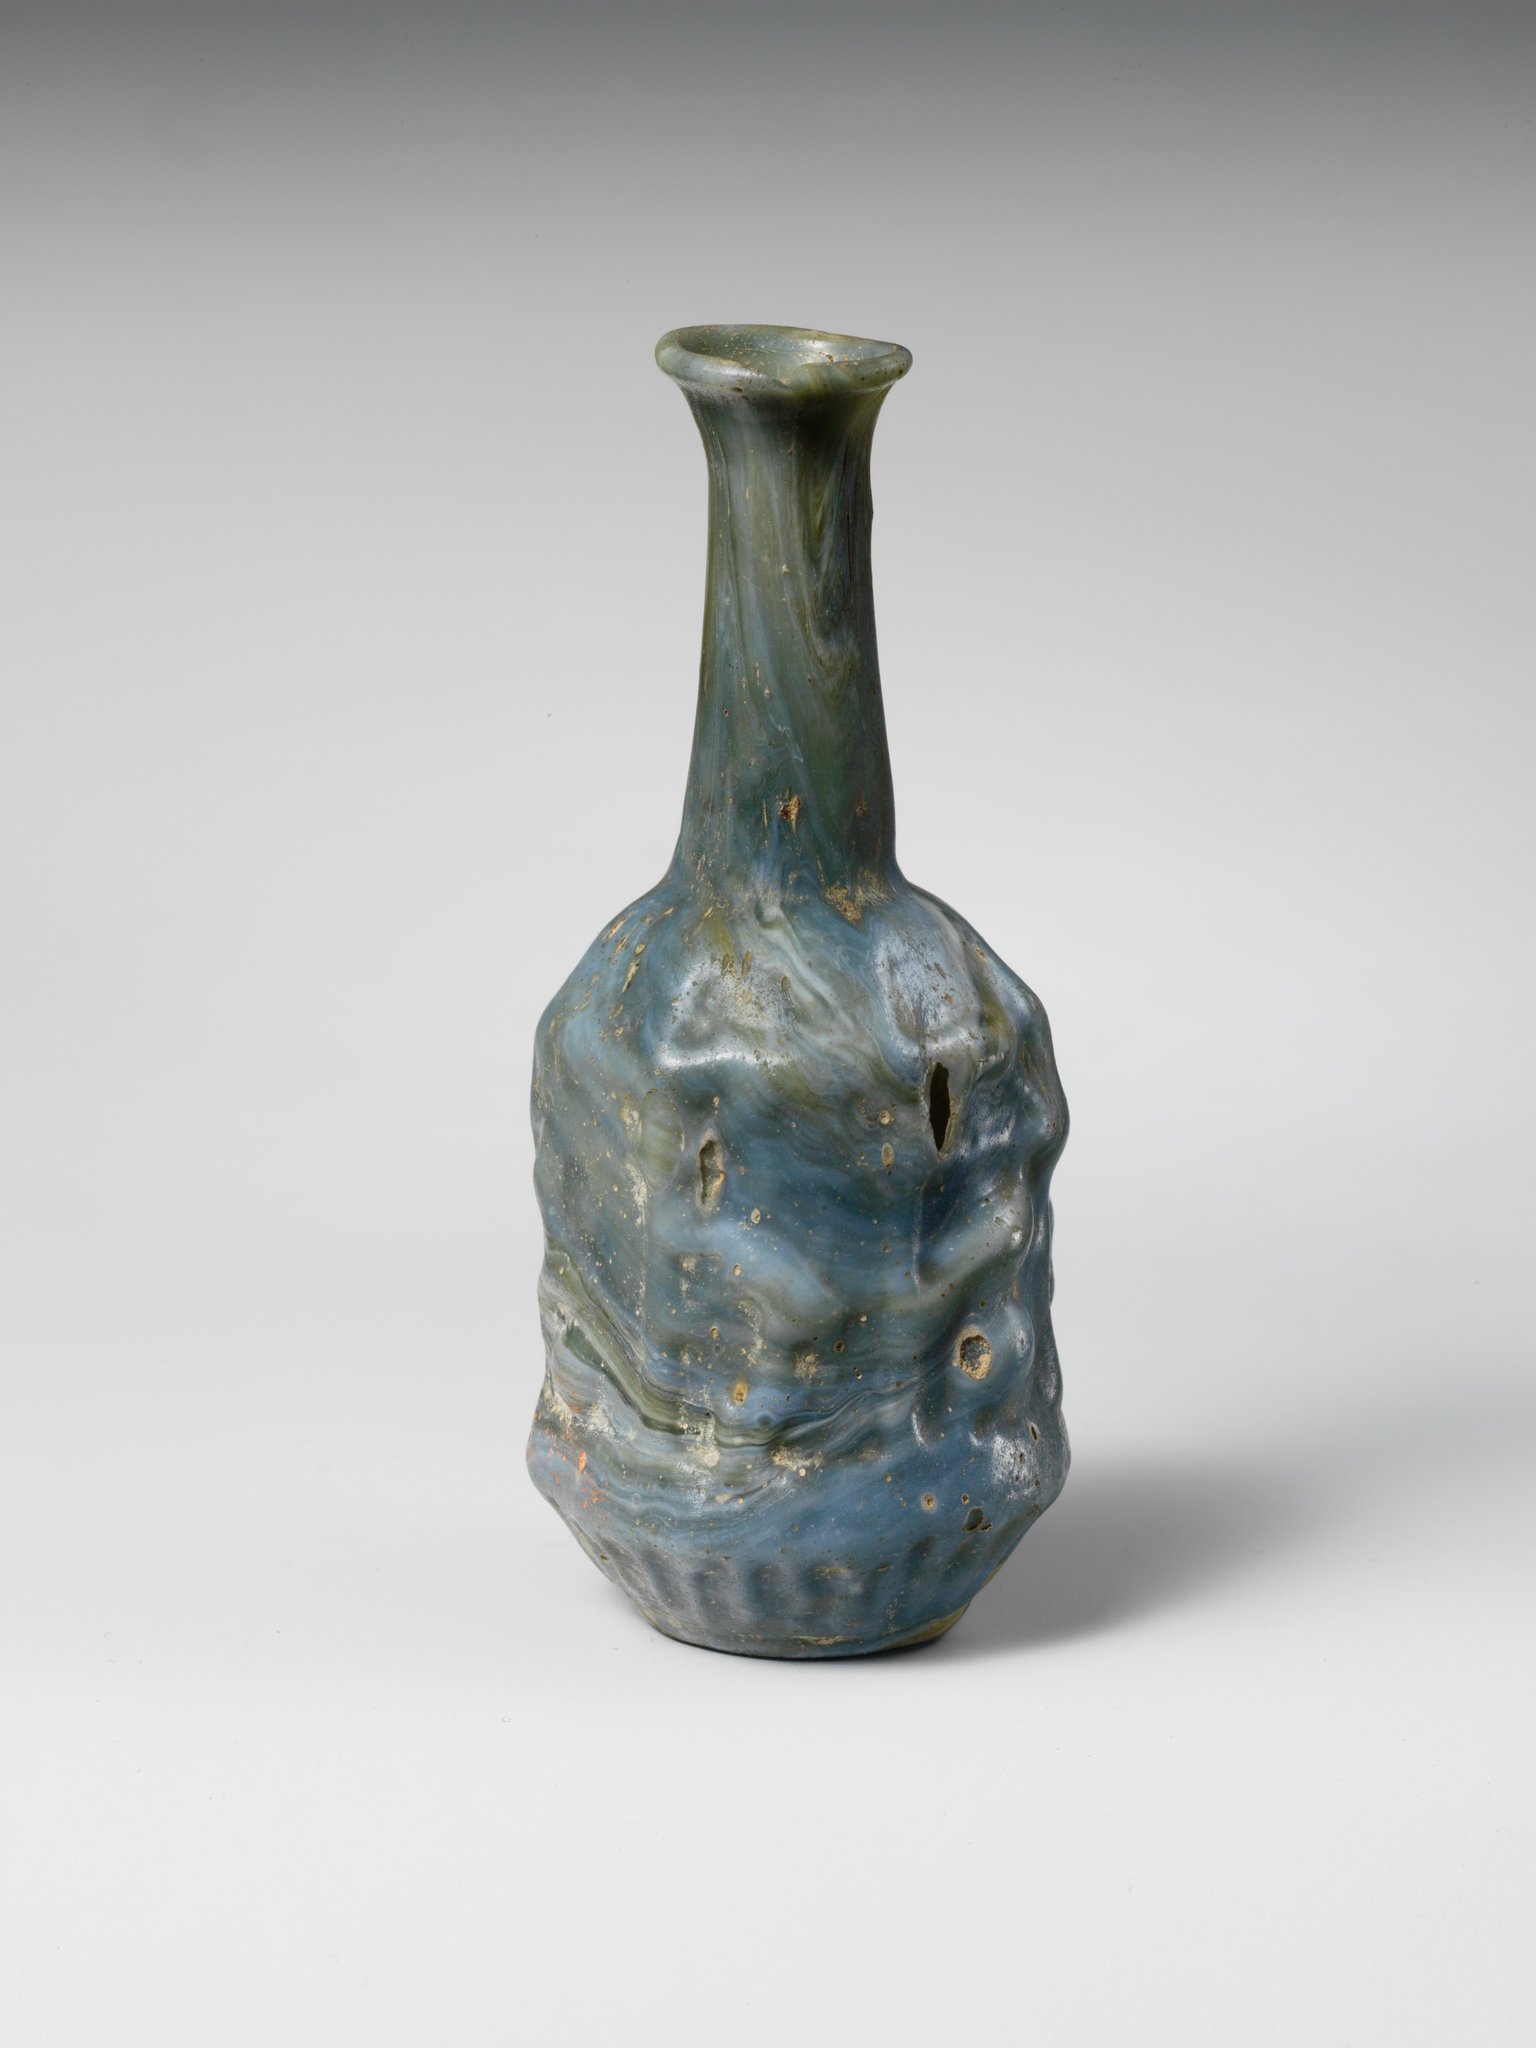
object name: bottle, hexagonal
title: Glass hexagonal bottle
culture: roman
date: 1-50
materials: glass